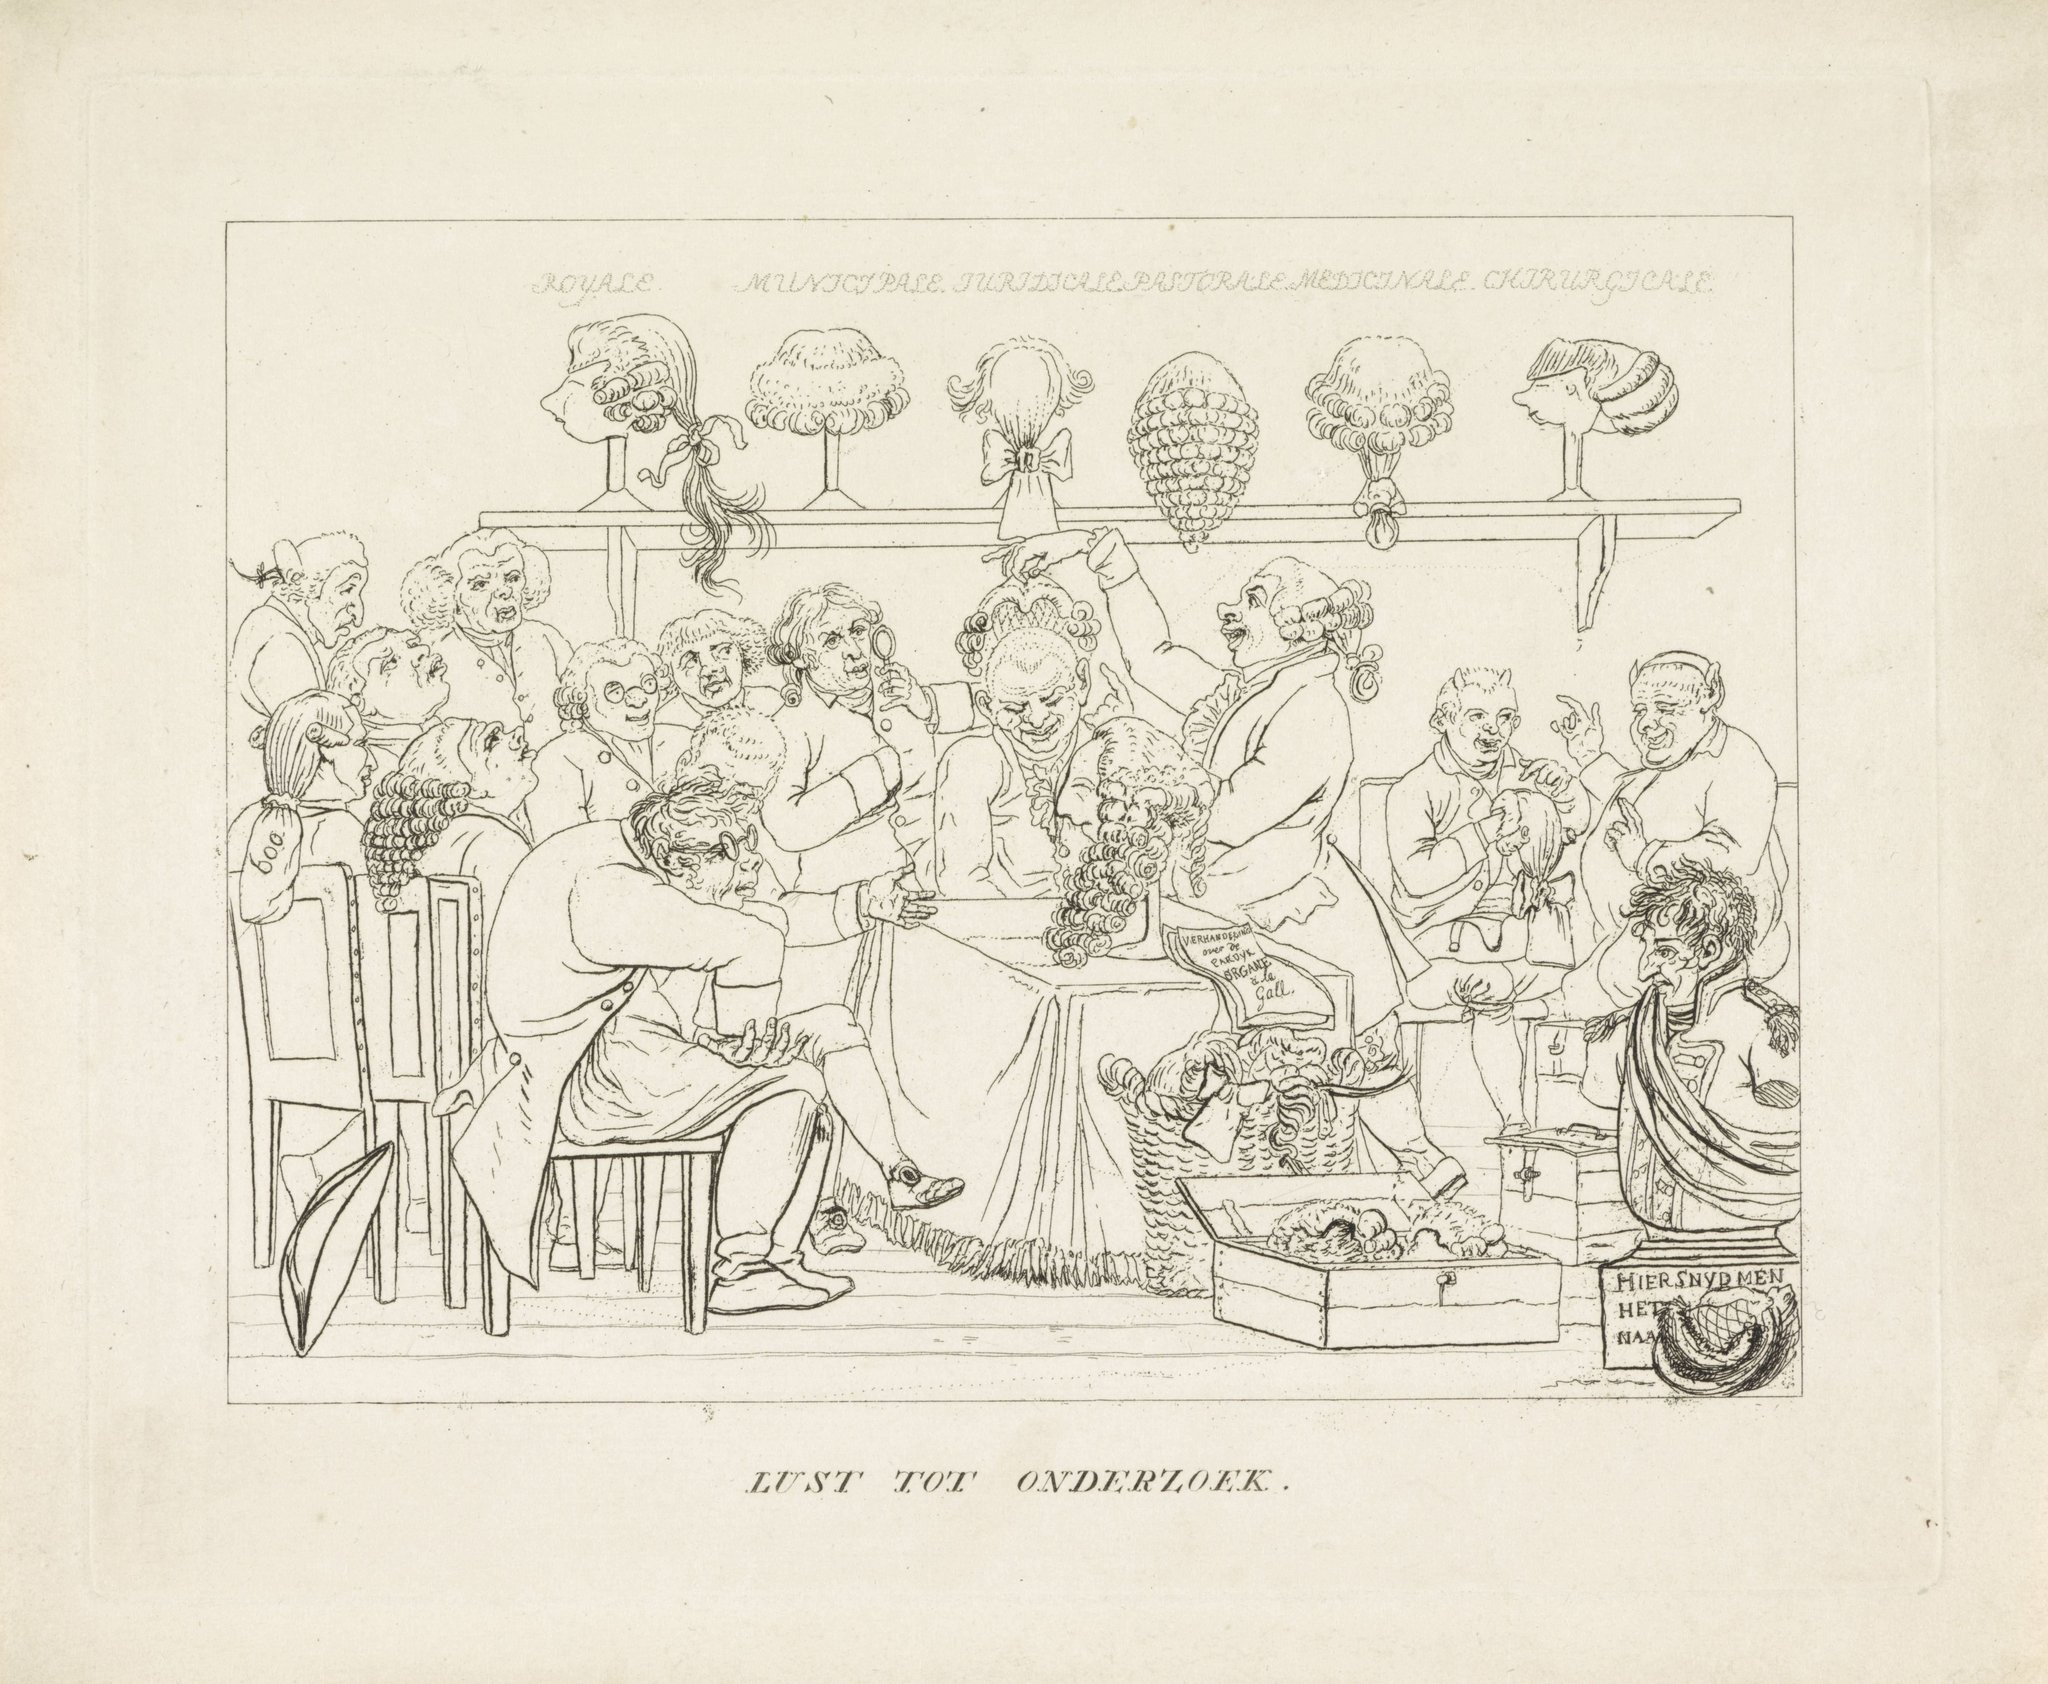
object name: print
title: Pruikenmaker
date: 1800-1805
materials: paper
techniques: etching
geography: netherlands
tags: wigmaker, 'perruquier', phrenology, caricatures (human types), wig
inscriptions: collector's mark: Lugt 2228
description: Een frenoloog zoekt als pruikenmaker de juiste pruik voor een man. Een grote groep zogenaamde wetenschappers kijkt toe. Op tafel ligt een verhandeling van de Duitse frenoloog Franz Joseph Gall. Onderdeel van een reeks van die karikaturale platen over de maatschappij rond 1800.